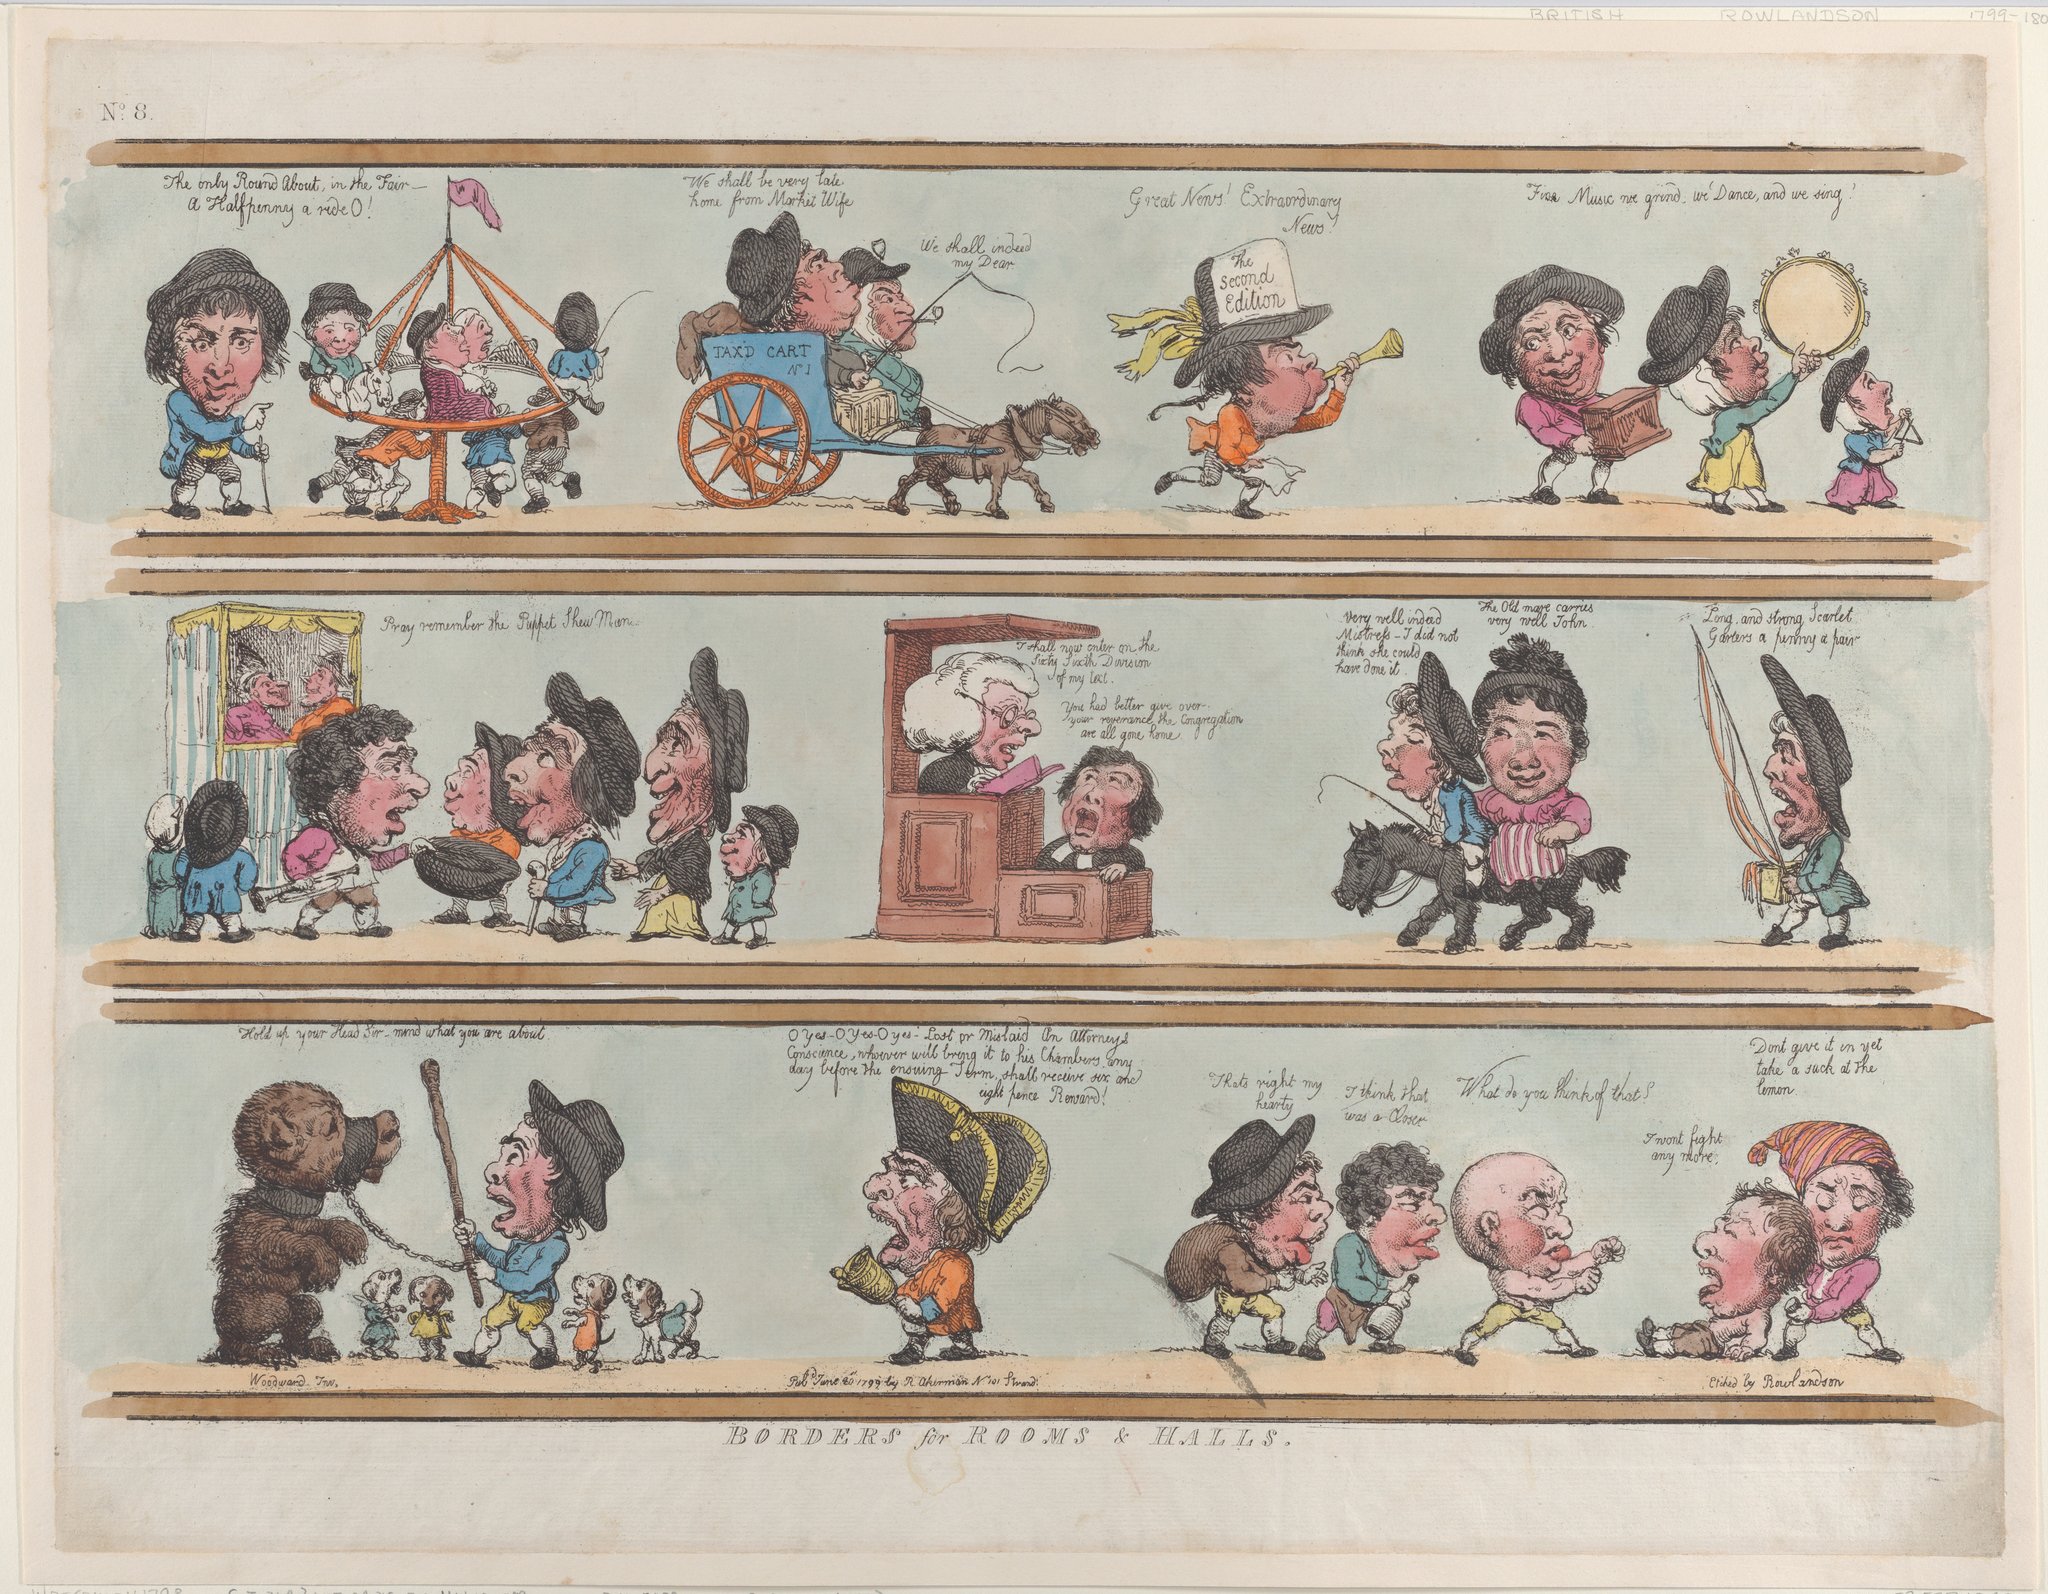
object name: print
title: Borders for Rooms & Halls, Plate 8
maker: thomas rowlandson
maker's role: artist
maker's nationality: british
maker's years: 1757-1827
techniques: etching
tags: satire,men,dogs